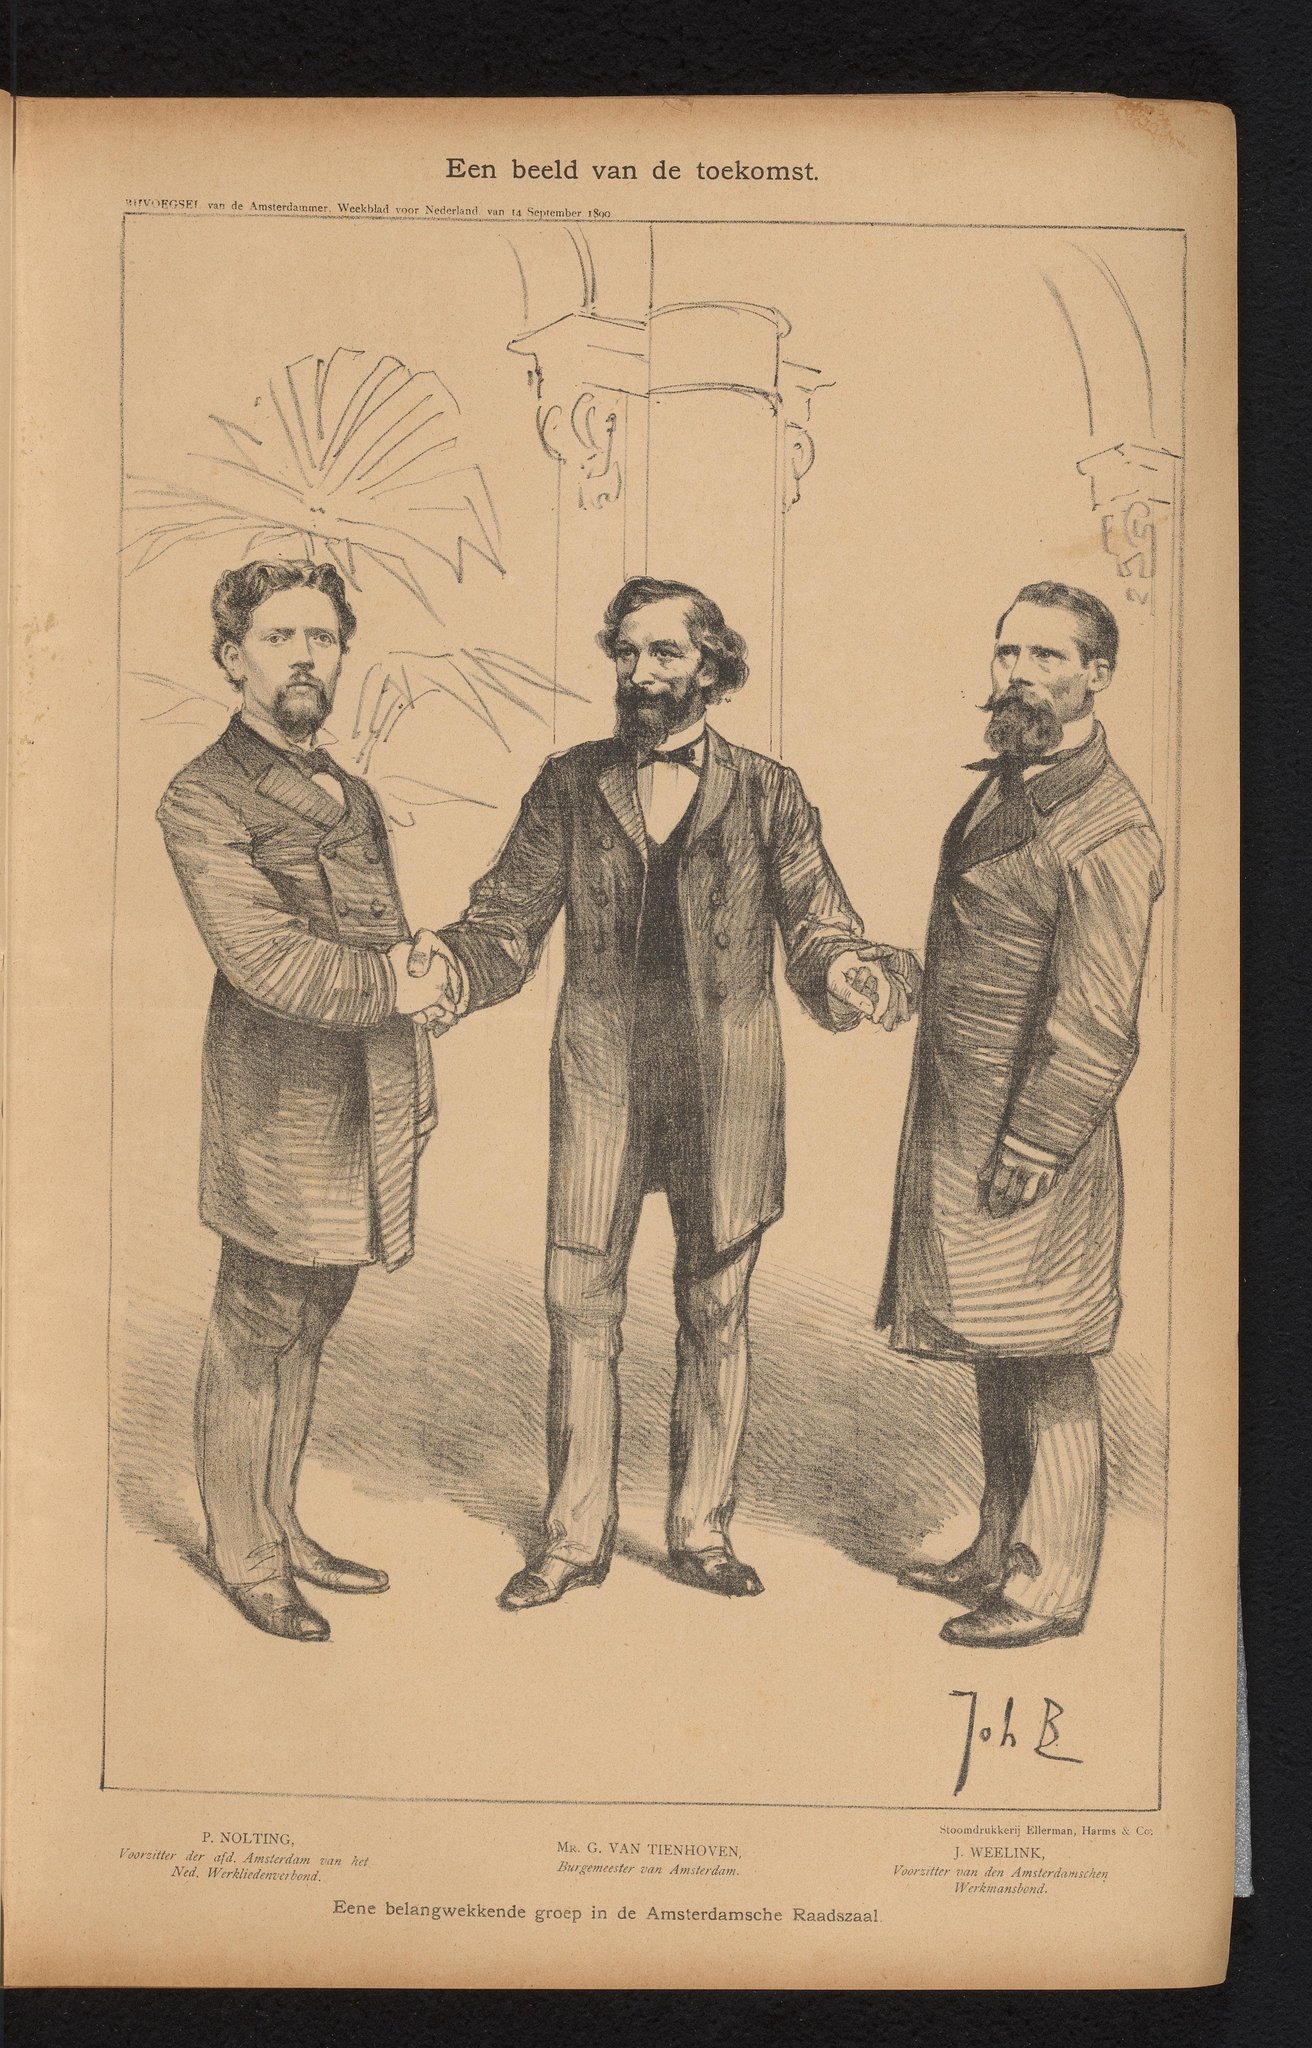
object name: print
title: Een beeld van de toekomst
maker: johan braakensiek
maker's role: draughtsman, print maker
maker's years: 1858-1940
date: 1890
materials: paper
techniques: lithograph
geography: netherlands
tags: amsterdam, mayor, gijsbert van tienhoven, modern professional organization, trade union, mayor, burgomaster, municipal government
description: De Amsterdamse burgemeester Van Tienhoven schudt de handen van de voorzitters van twee Amsterdamse vakcentrales, P. Nolting en J. Weelink, in de Amsterdamse Raadszaal.